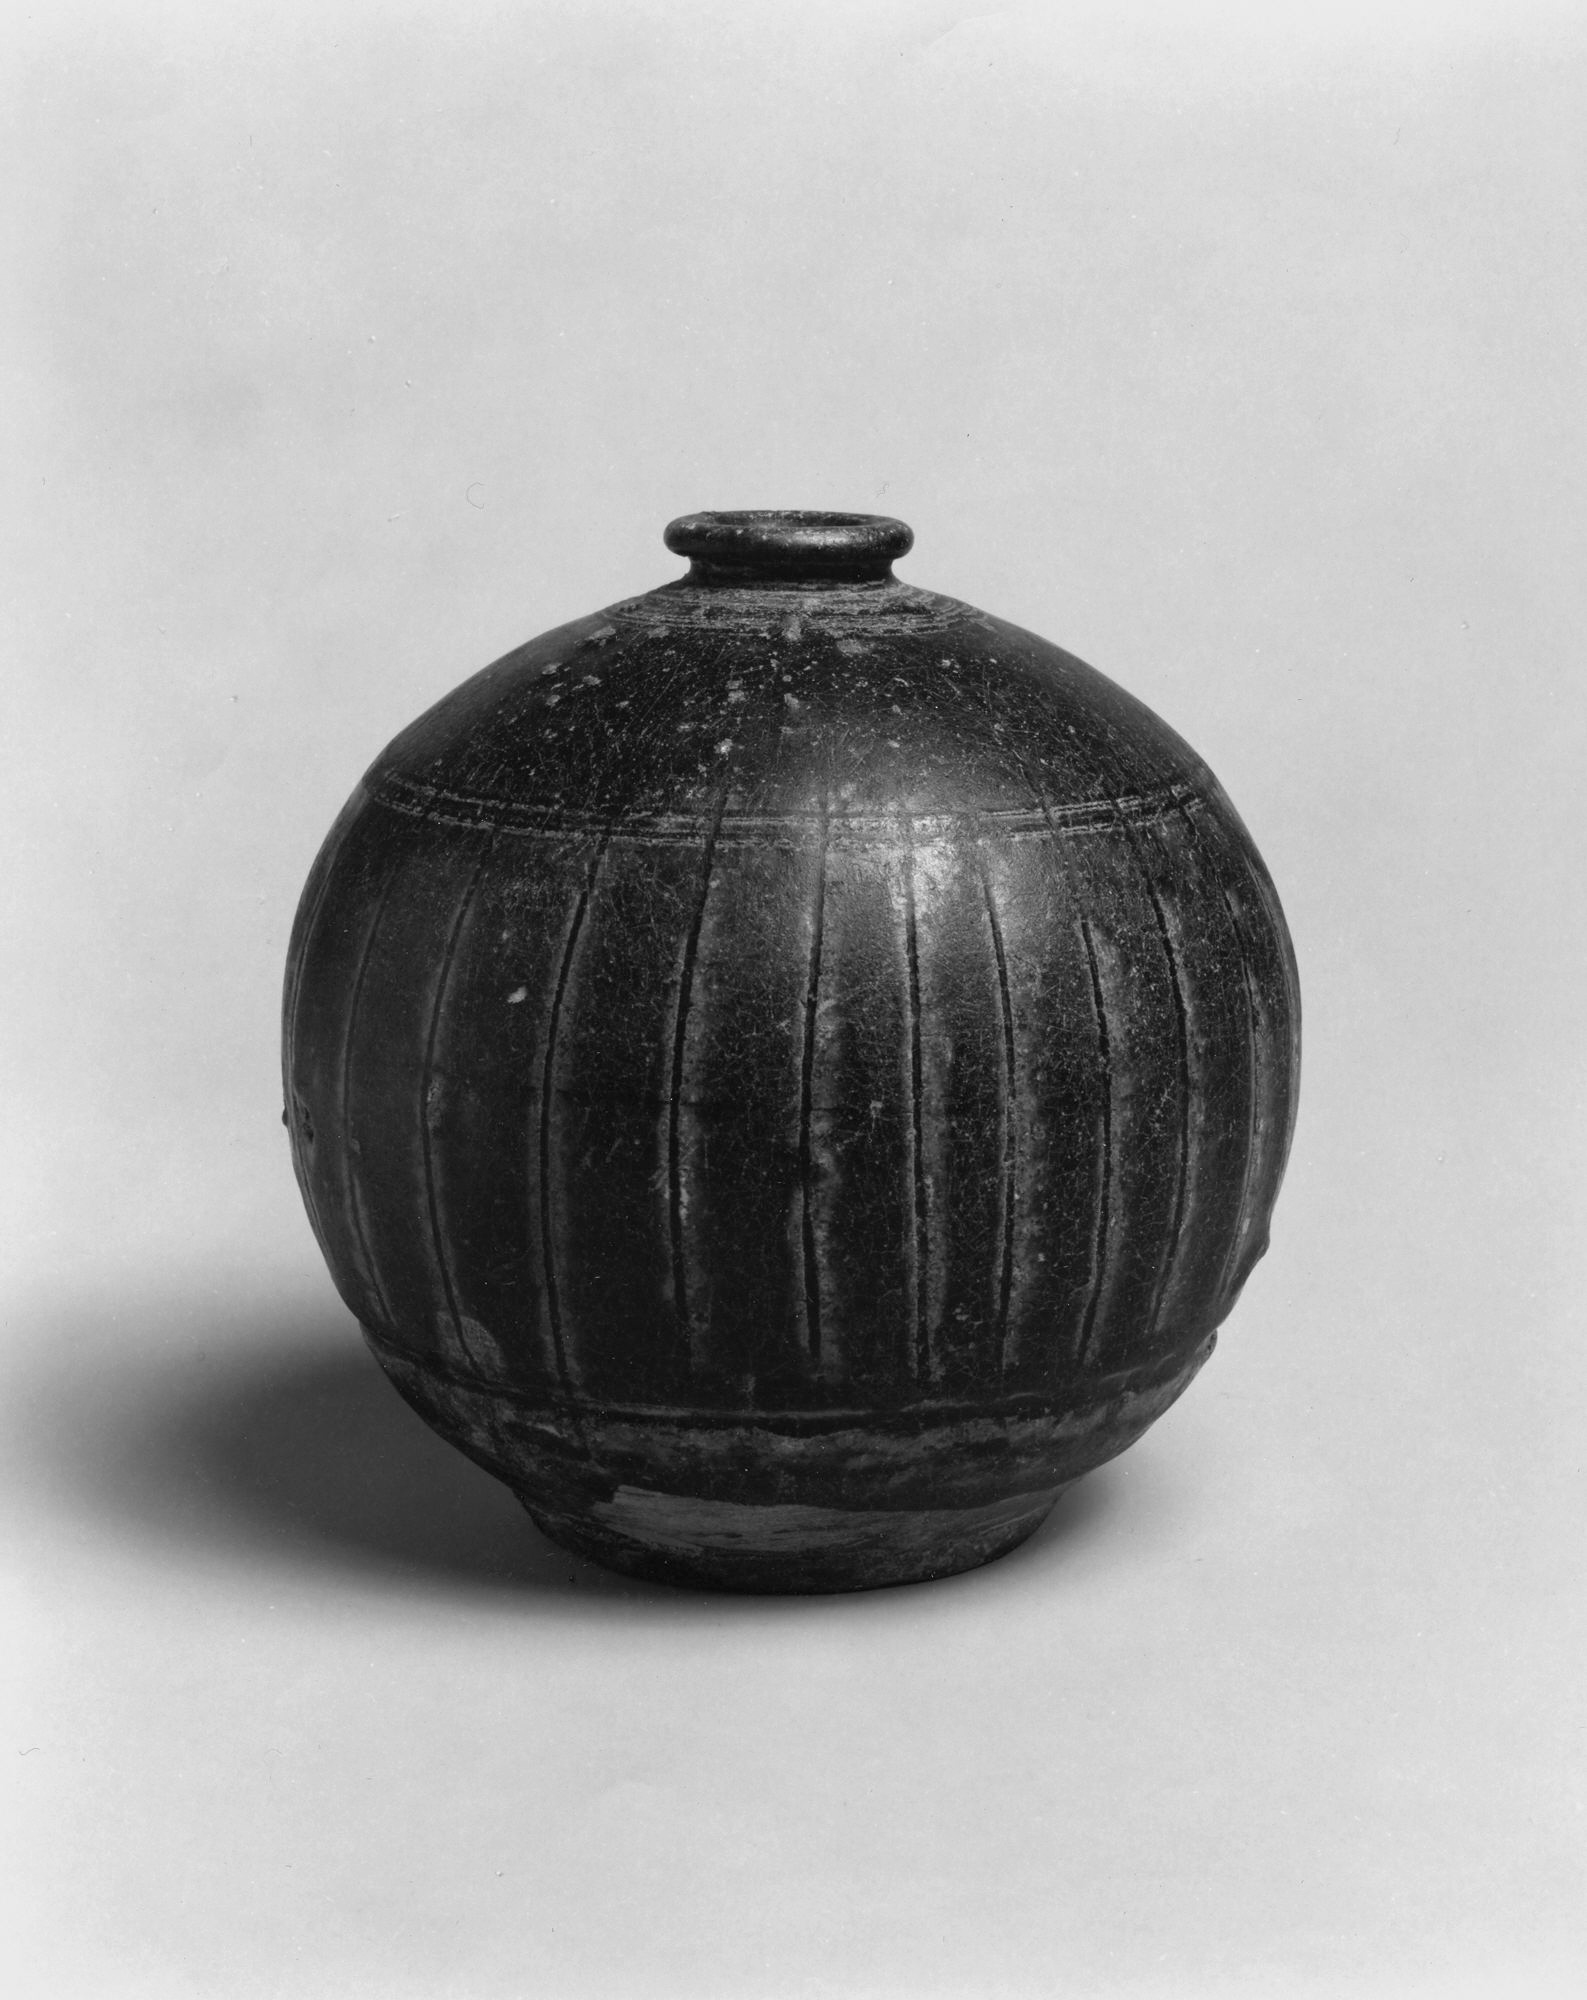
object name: jar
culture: thai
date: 1067-1200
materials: ceramic